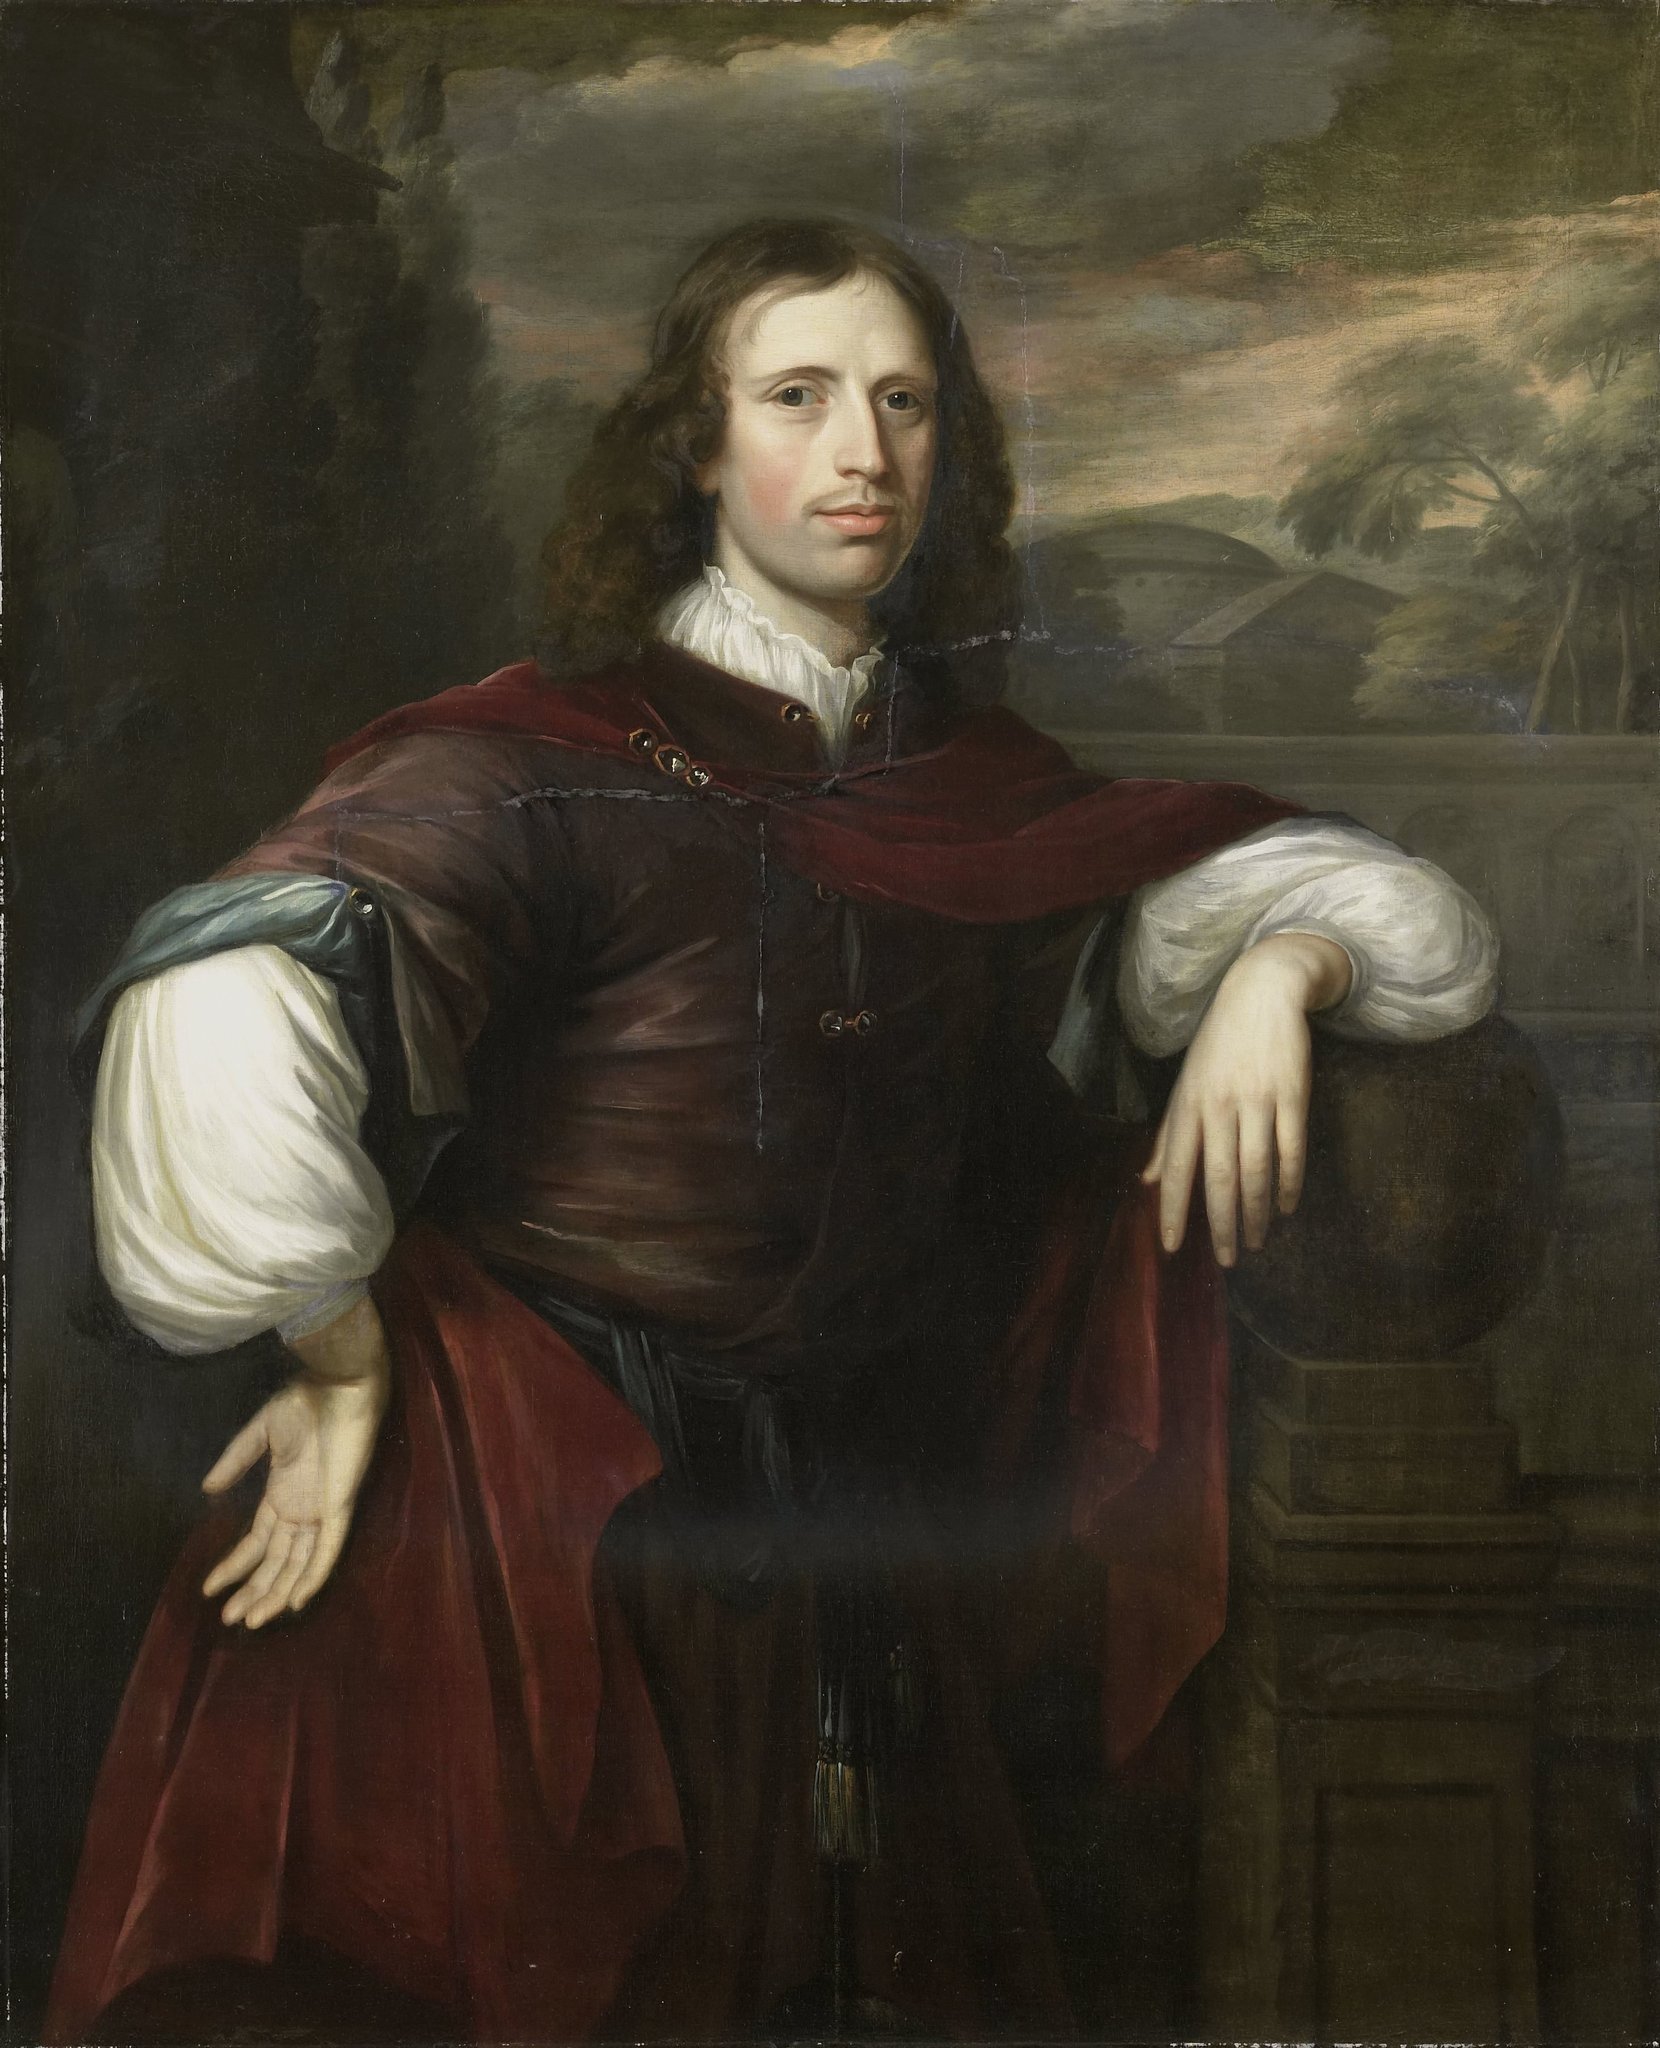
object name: painting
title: Portrait of a Man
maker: herman verelst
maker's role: painter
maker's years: 1641-1702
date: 1667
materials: canvas, oil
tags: anonymous historical person portrayed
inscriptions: signature and date: ‘H. Verelst. F. Aº 1667’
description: Portret van een man. Kniestuk, staande met de linkerarm geleund op een balustrade, de rechterhand in de zij. Op de achtergrond een landschap. Pendant van SK-C-25.